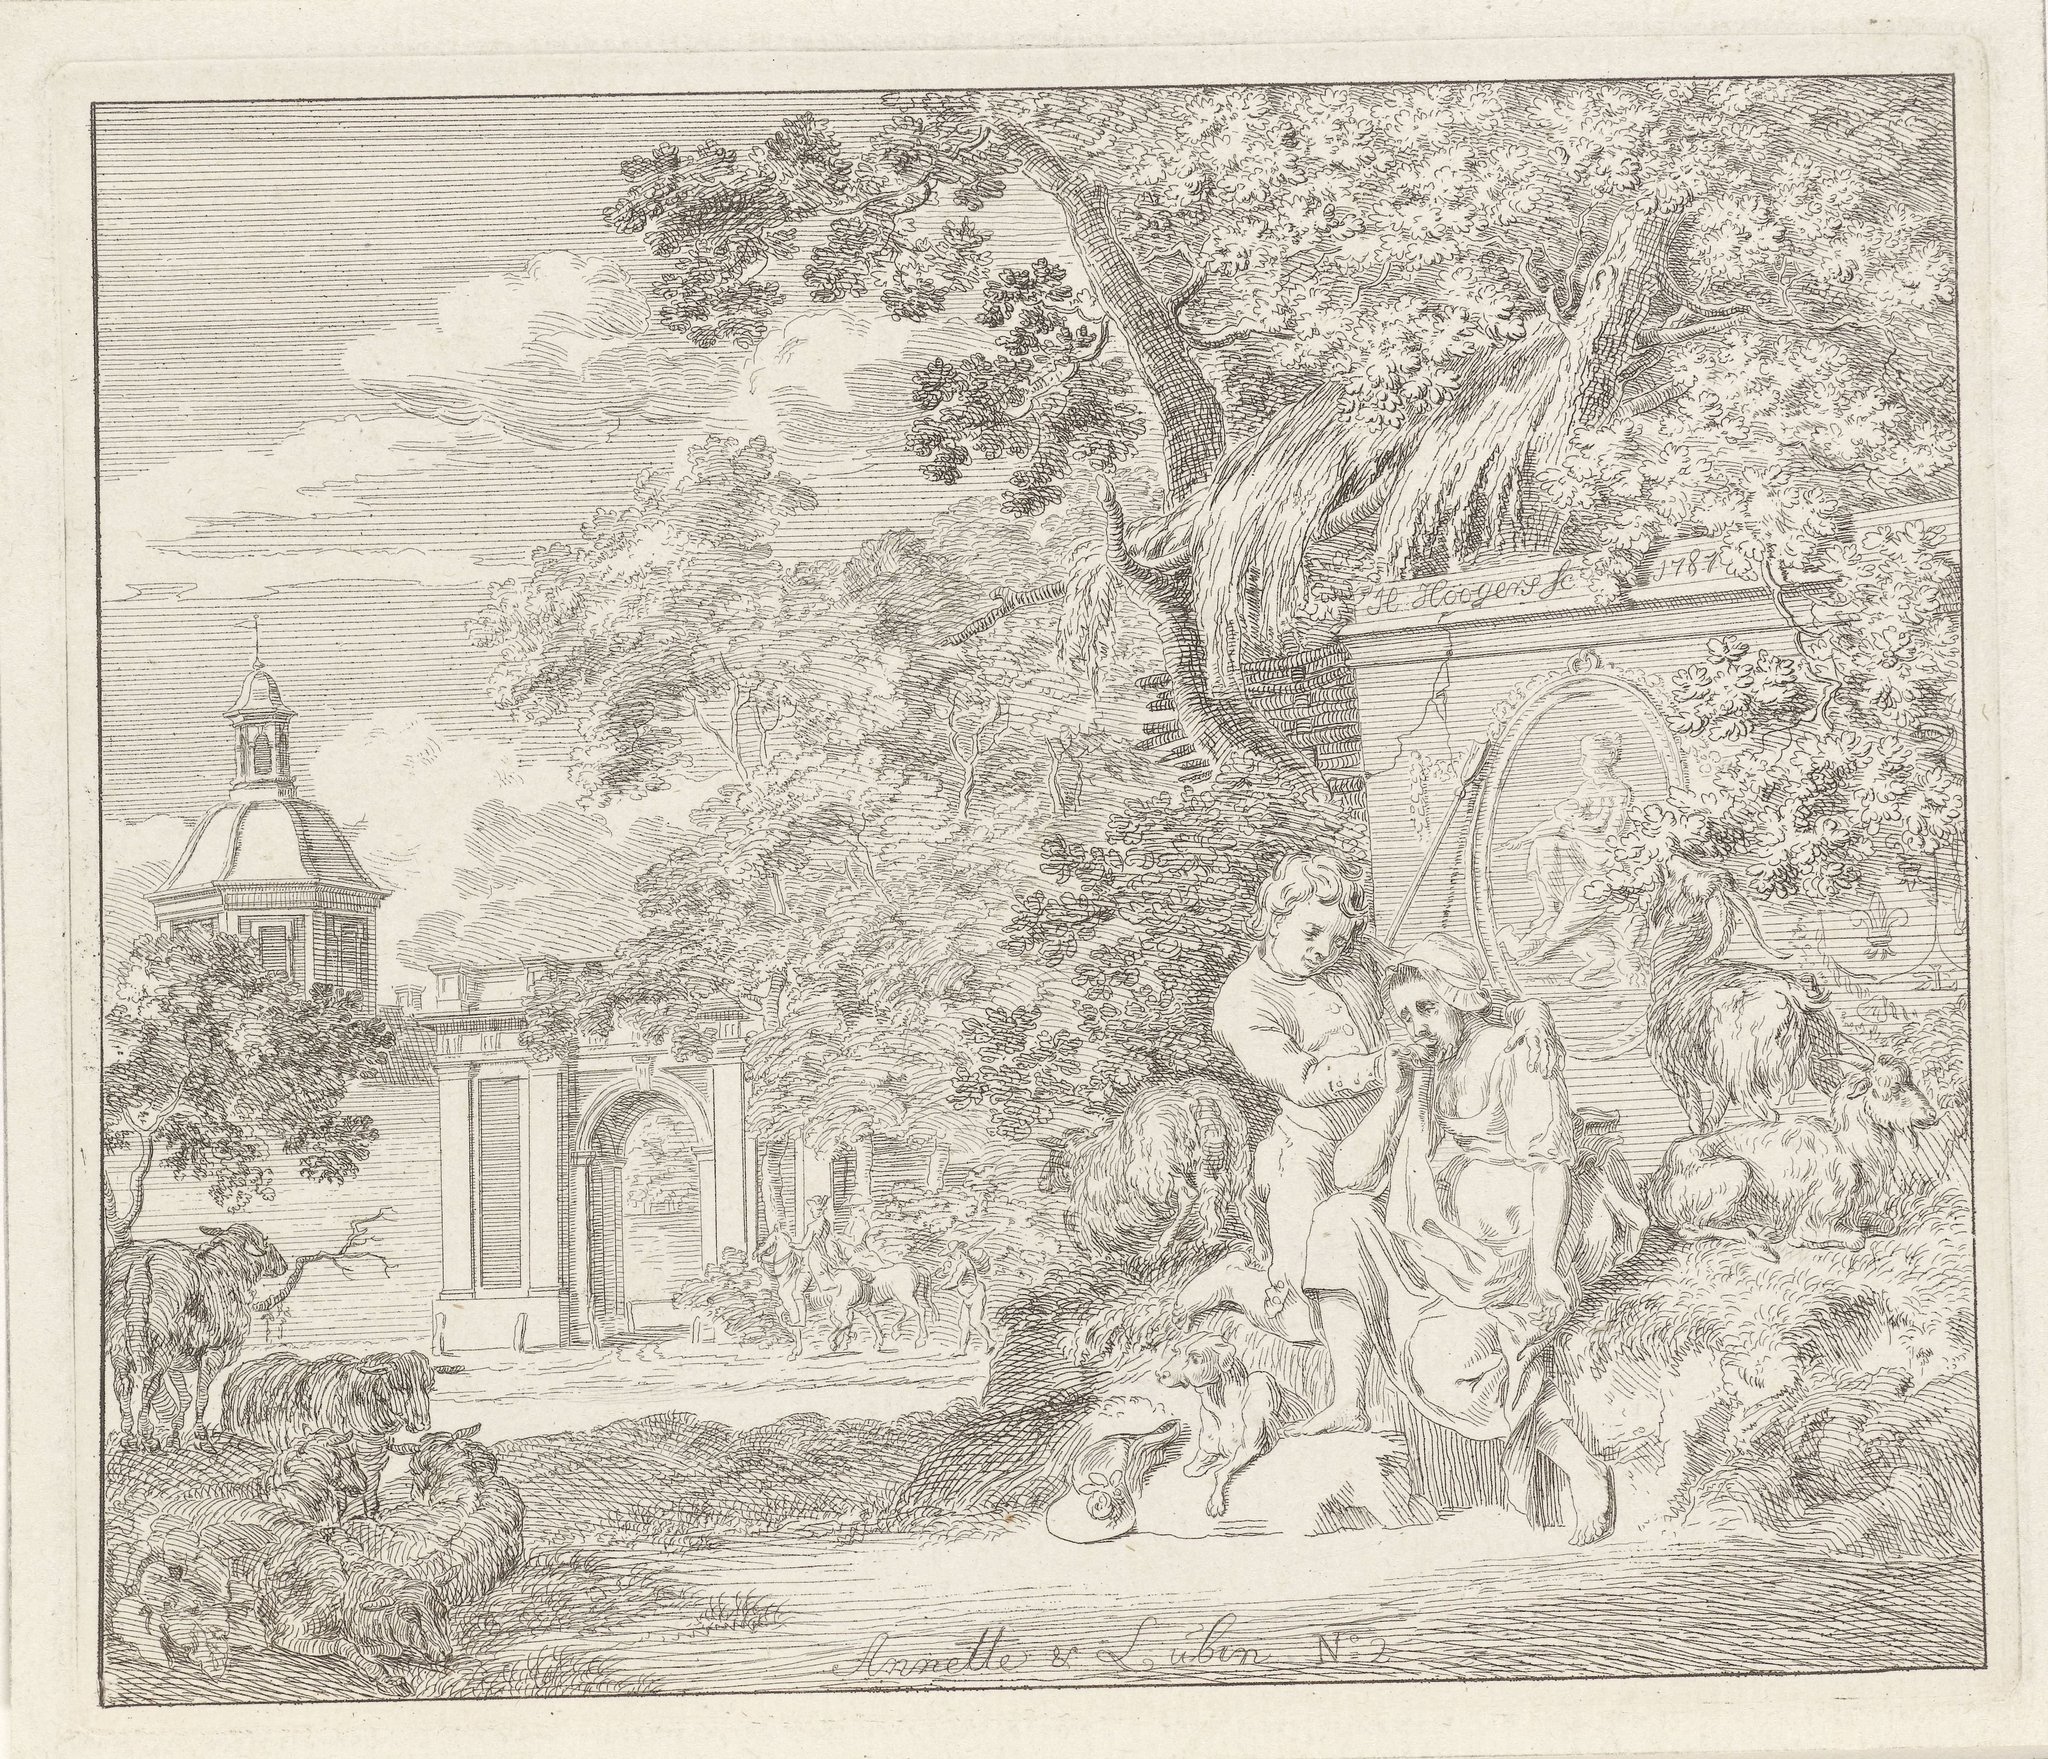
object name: print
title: Paar bij een klassiek monument en een stadspoort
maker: hendrik hoogers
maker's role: draughtsman, mayor, print maker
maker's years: 1747-1814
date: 1787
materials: paper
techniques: etching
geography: nijmegen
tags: herding, herdsman, herdswoman, shepherd, shepherdess, cowherd, etc., pastorals, arcadian scenes, crying, shouting (+ being sad, suffering, sorrowing)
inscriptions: collector's mark: Lugt 2228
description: De voorstelling heeft betrekking op: Marie Justine Benoîte Favart, [vertaald door] P.F. Lynslager, Annette en Lubyn, tooneelspel; met zang. Amsterdam, J. Helders en A. Mars, 1790.